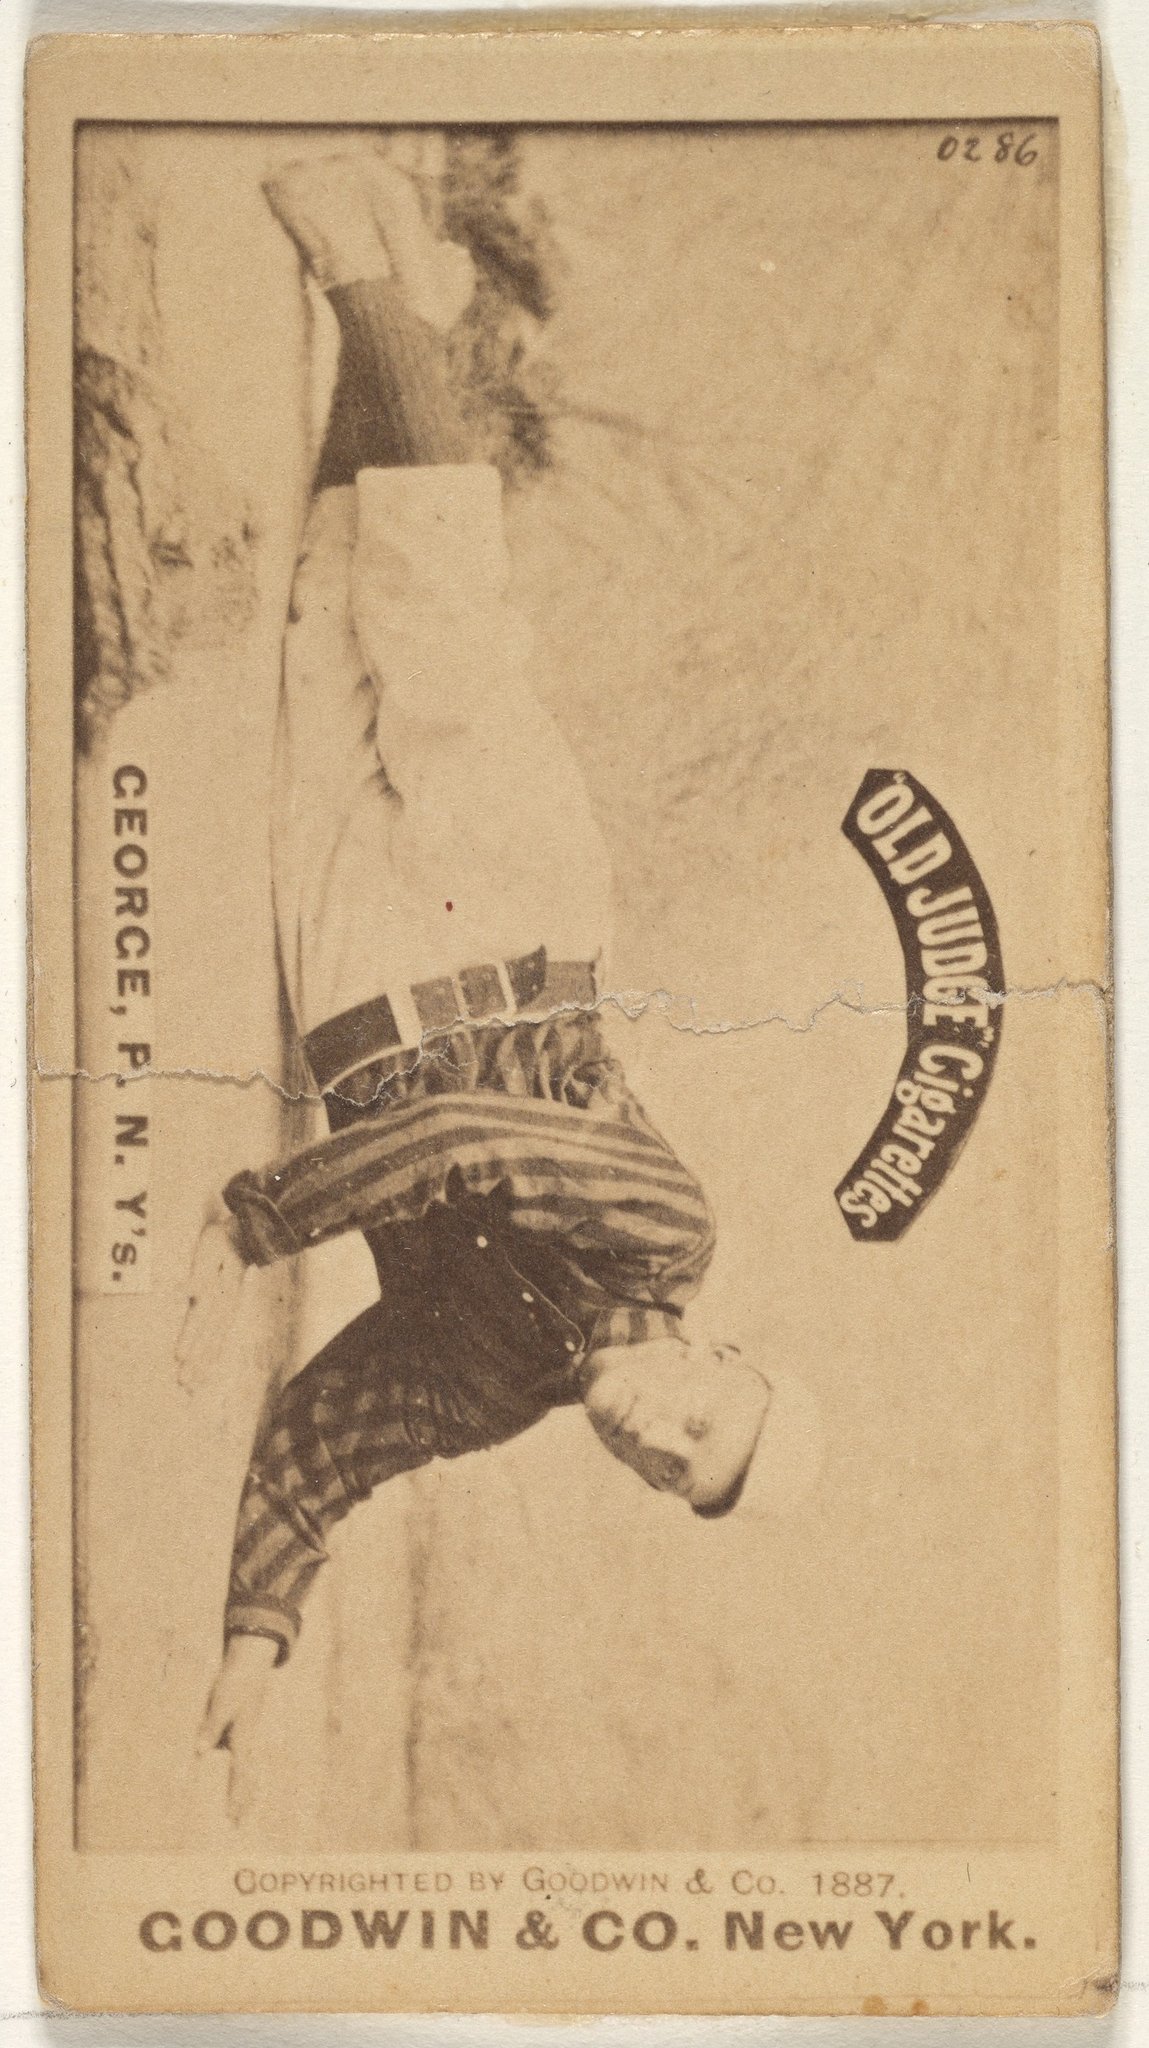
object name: baseball card, photograph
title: Bill George, Pitcher, New York, from the Old Judge series (N172) for Old Judge Cigarettes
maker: goodwin & company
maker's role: publisher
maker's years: 1850-1950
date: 1887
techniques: albumen silver print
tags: men,portraits,baseball,athletes